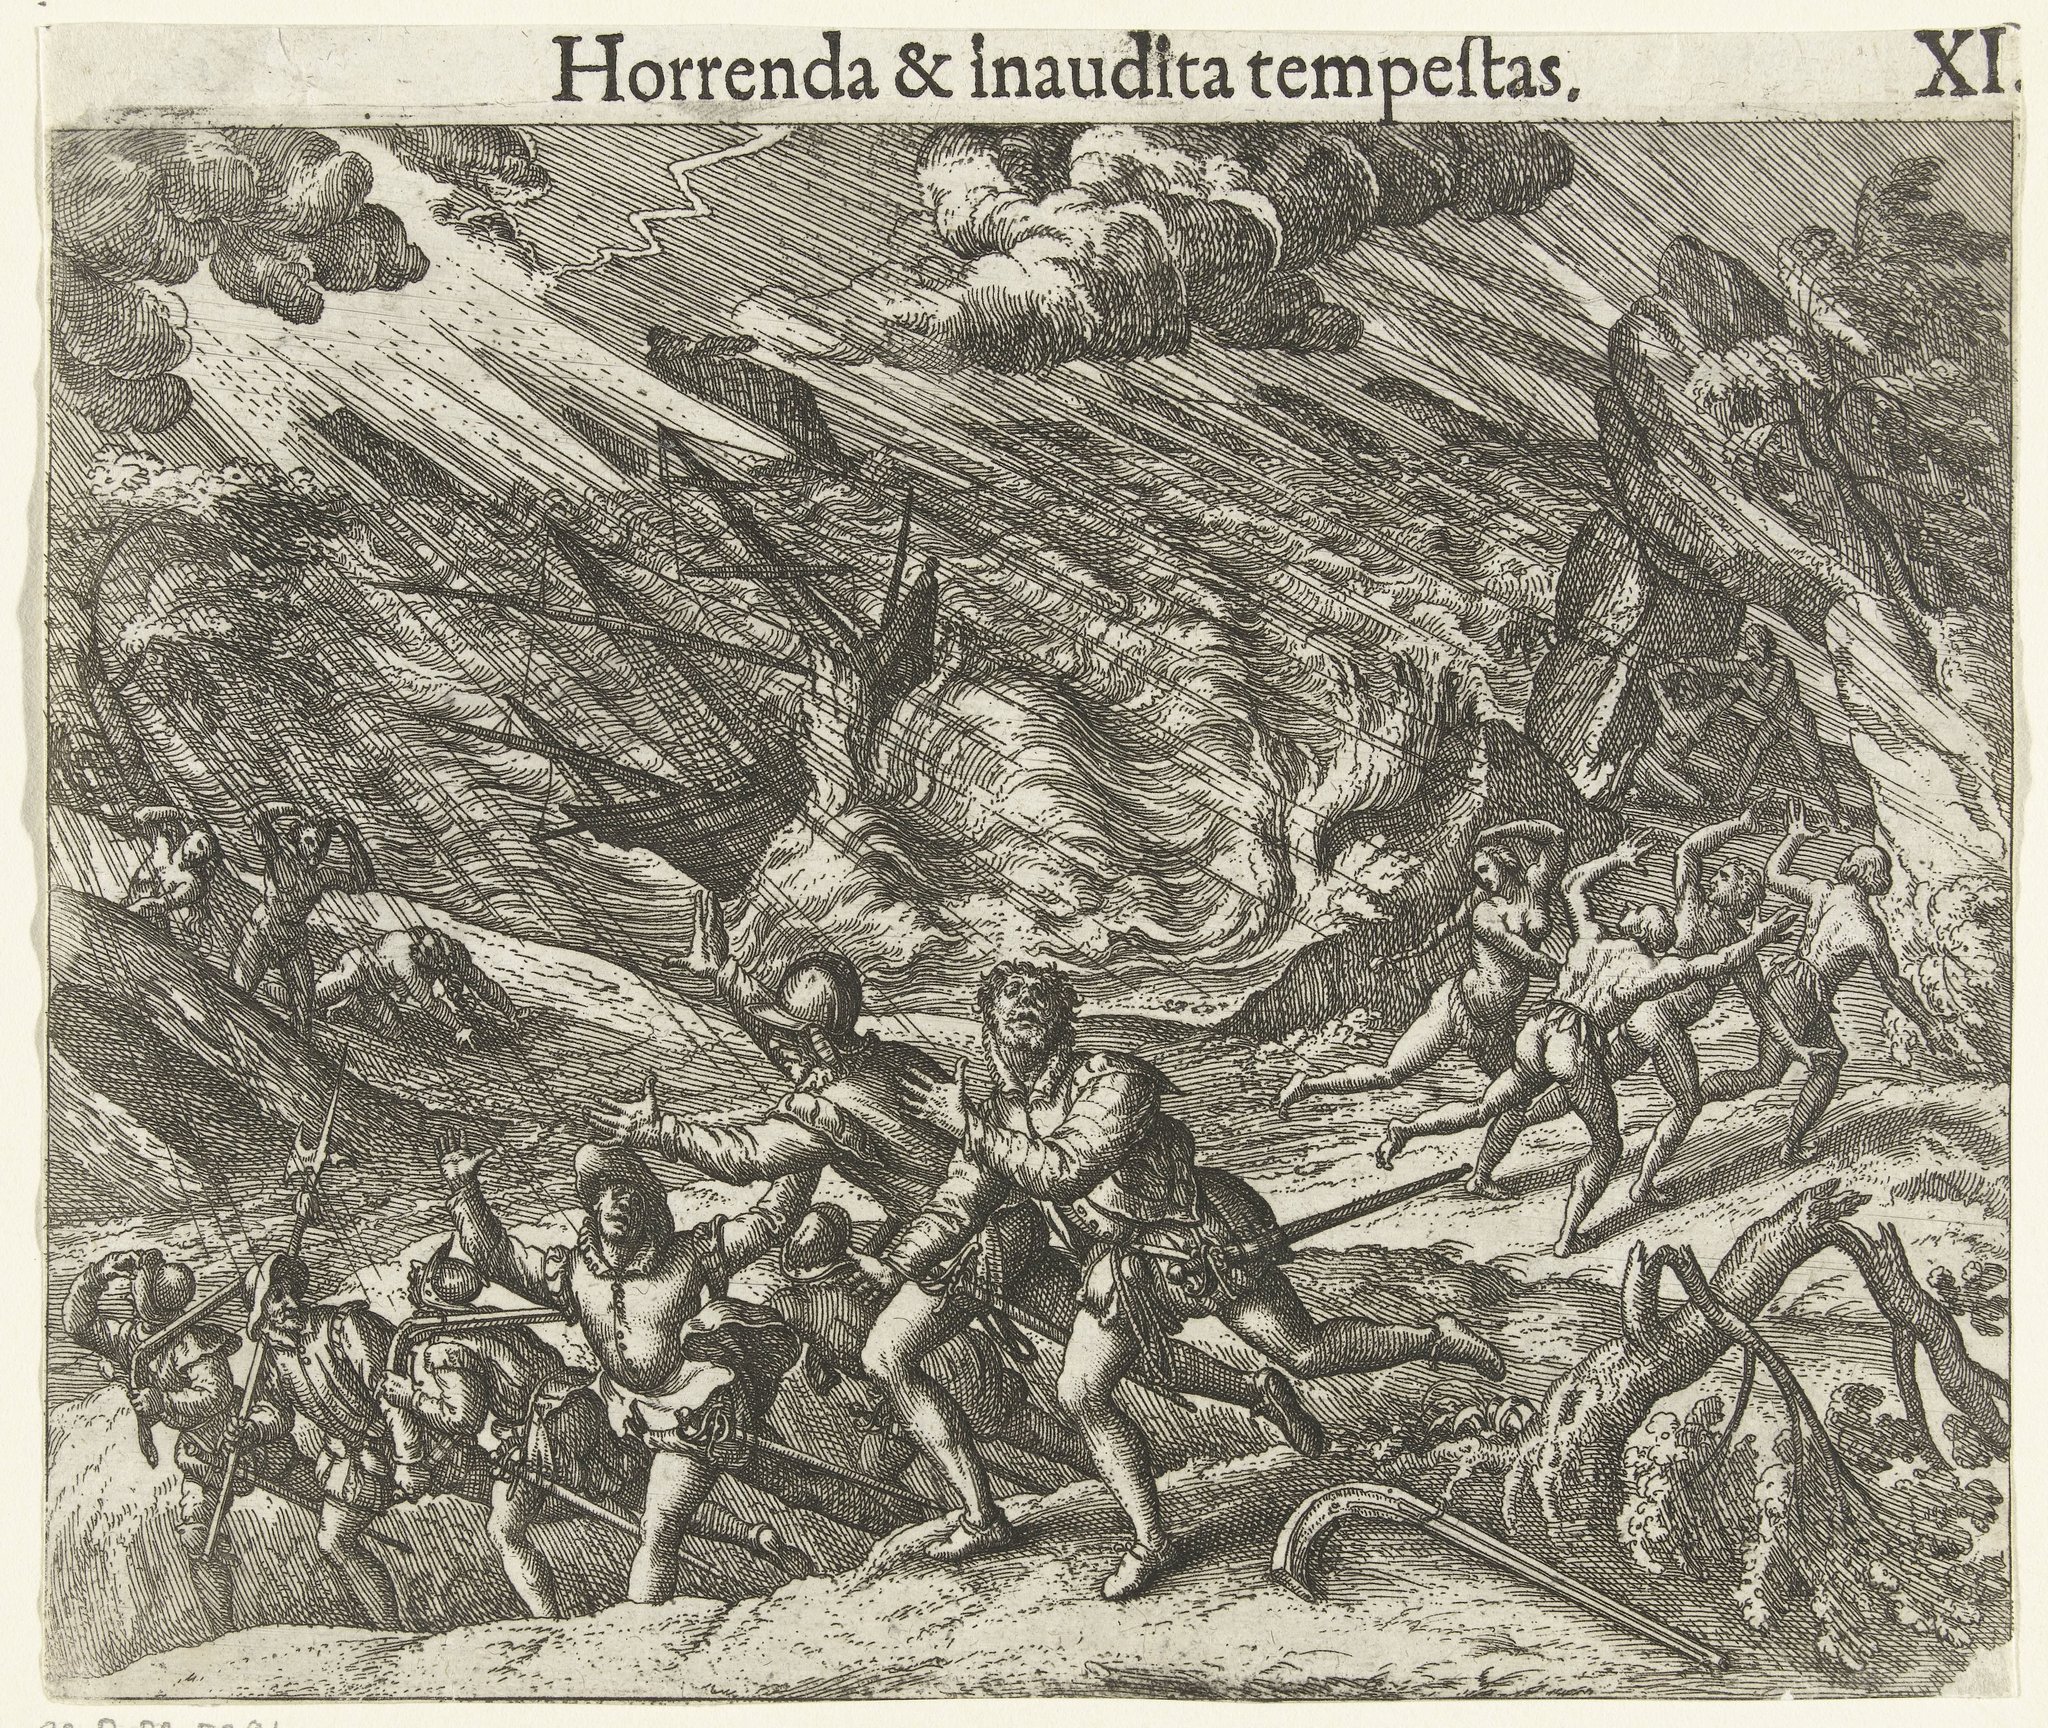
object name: print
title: Zware storm overvalt Europeanen en lokale bevolking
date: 1594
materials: paper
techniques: etching, letterpress printing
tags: whirlwind, cyclone, hurricane, typhoon, tornado at sea, storm at sea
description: Afkomstig uit: Collectiones peregrinationum in Indiam occidentalem, dl. 4: Girolamo Benzoni, Americae pars quarta. Sive, Insignis & admiranda historia de reperta primum occidentali India à Christophoro Columbo. Frankfurt am Main: T. de Bry, 1594.